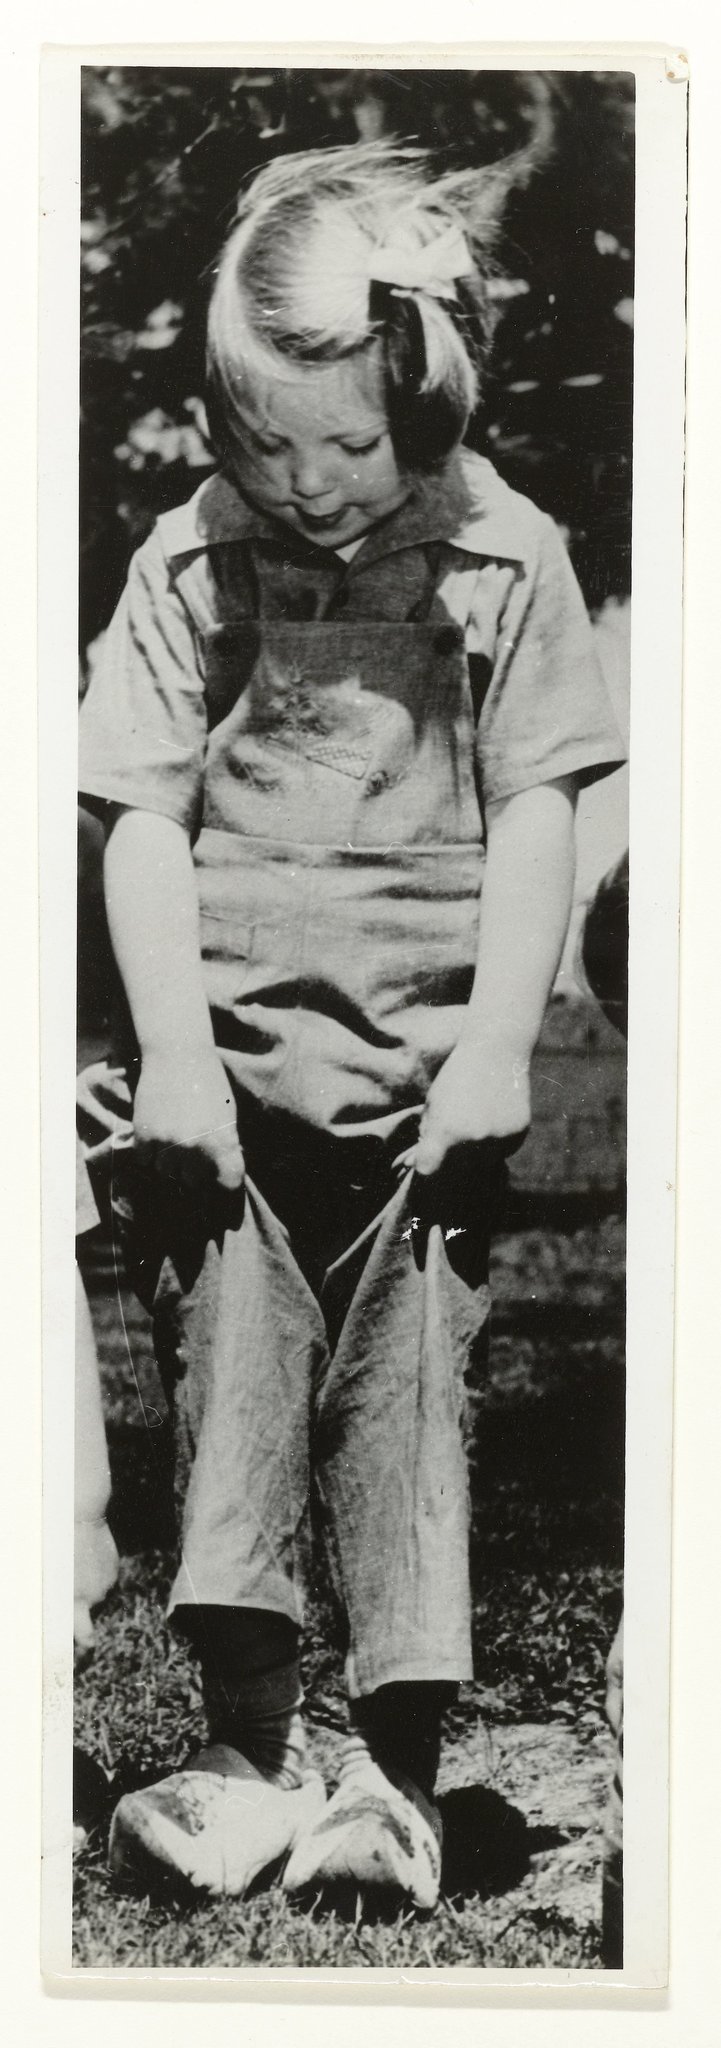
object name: photograph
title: Beatrix in Canada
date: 1945-1946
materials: photographic support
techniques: photography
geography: canada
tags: beatrix (koningin der nederlanden), canada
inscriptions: stamp: ‘COPYRIGHT / 'ANEFO' / ALGEMEEN NEDERLANDSCH FOTOBUREAU’, inscription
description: Prinses Beatrix, op klompen, in Canada, kort voor haar 8ste verjaardag